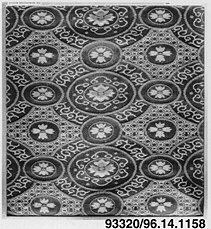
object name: piece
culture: japanese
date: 1701-1900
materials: silk